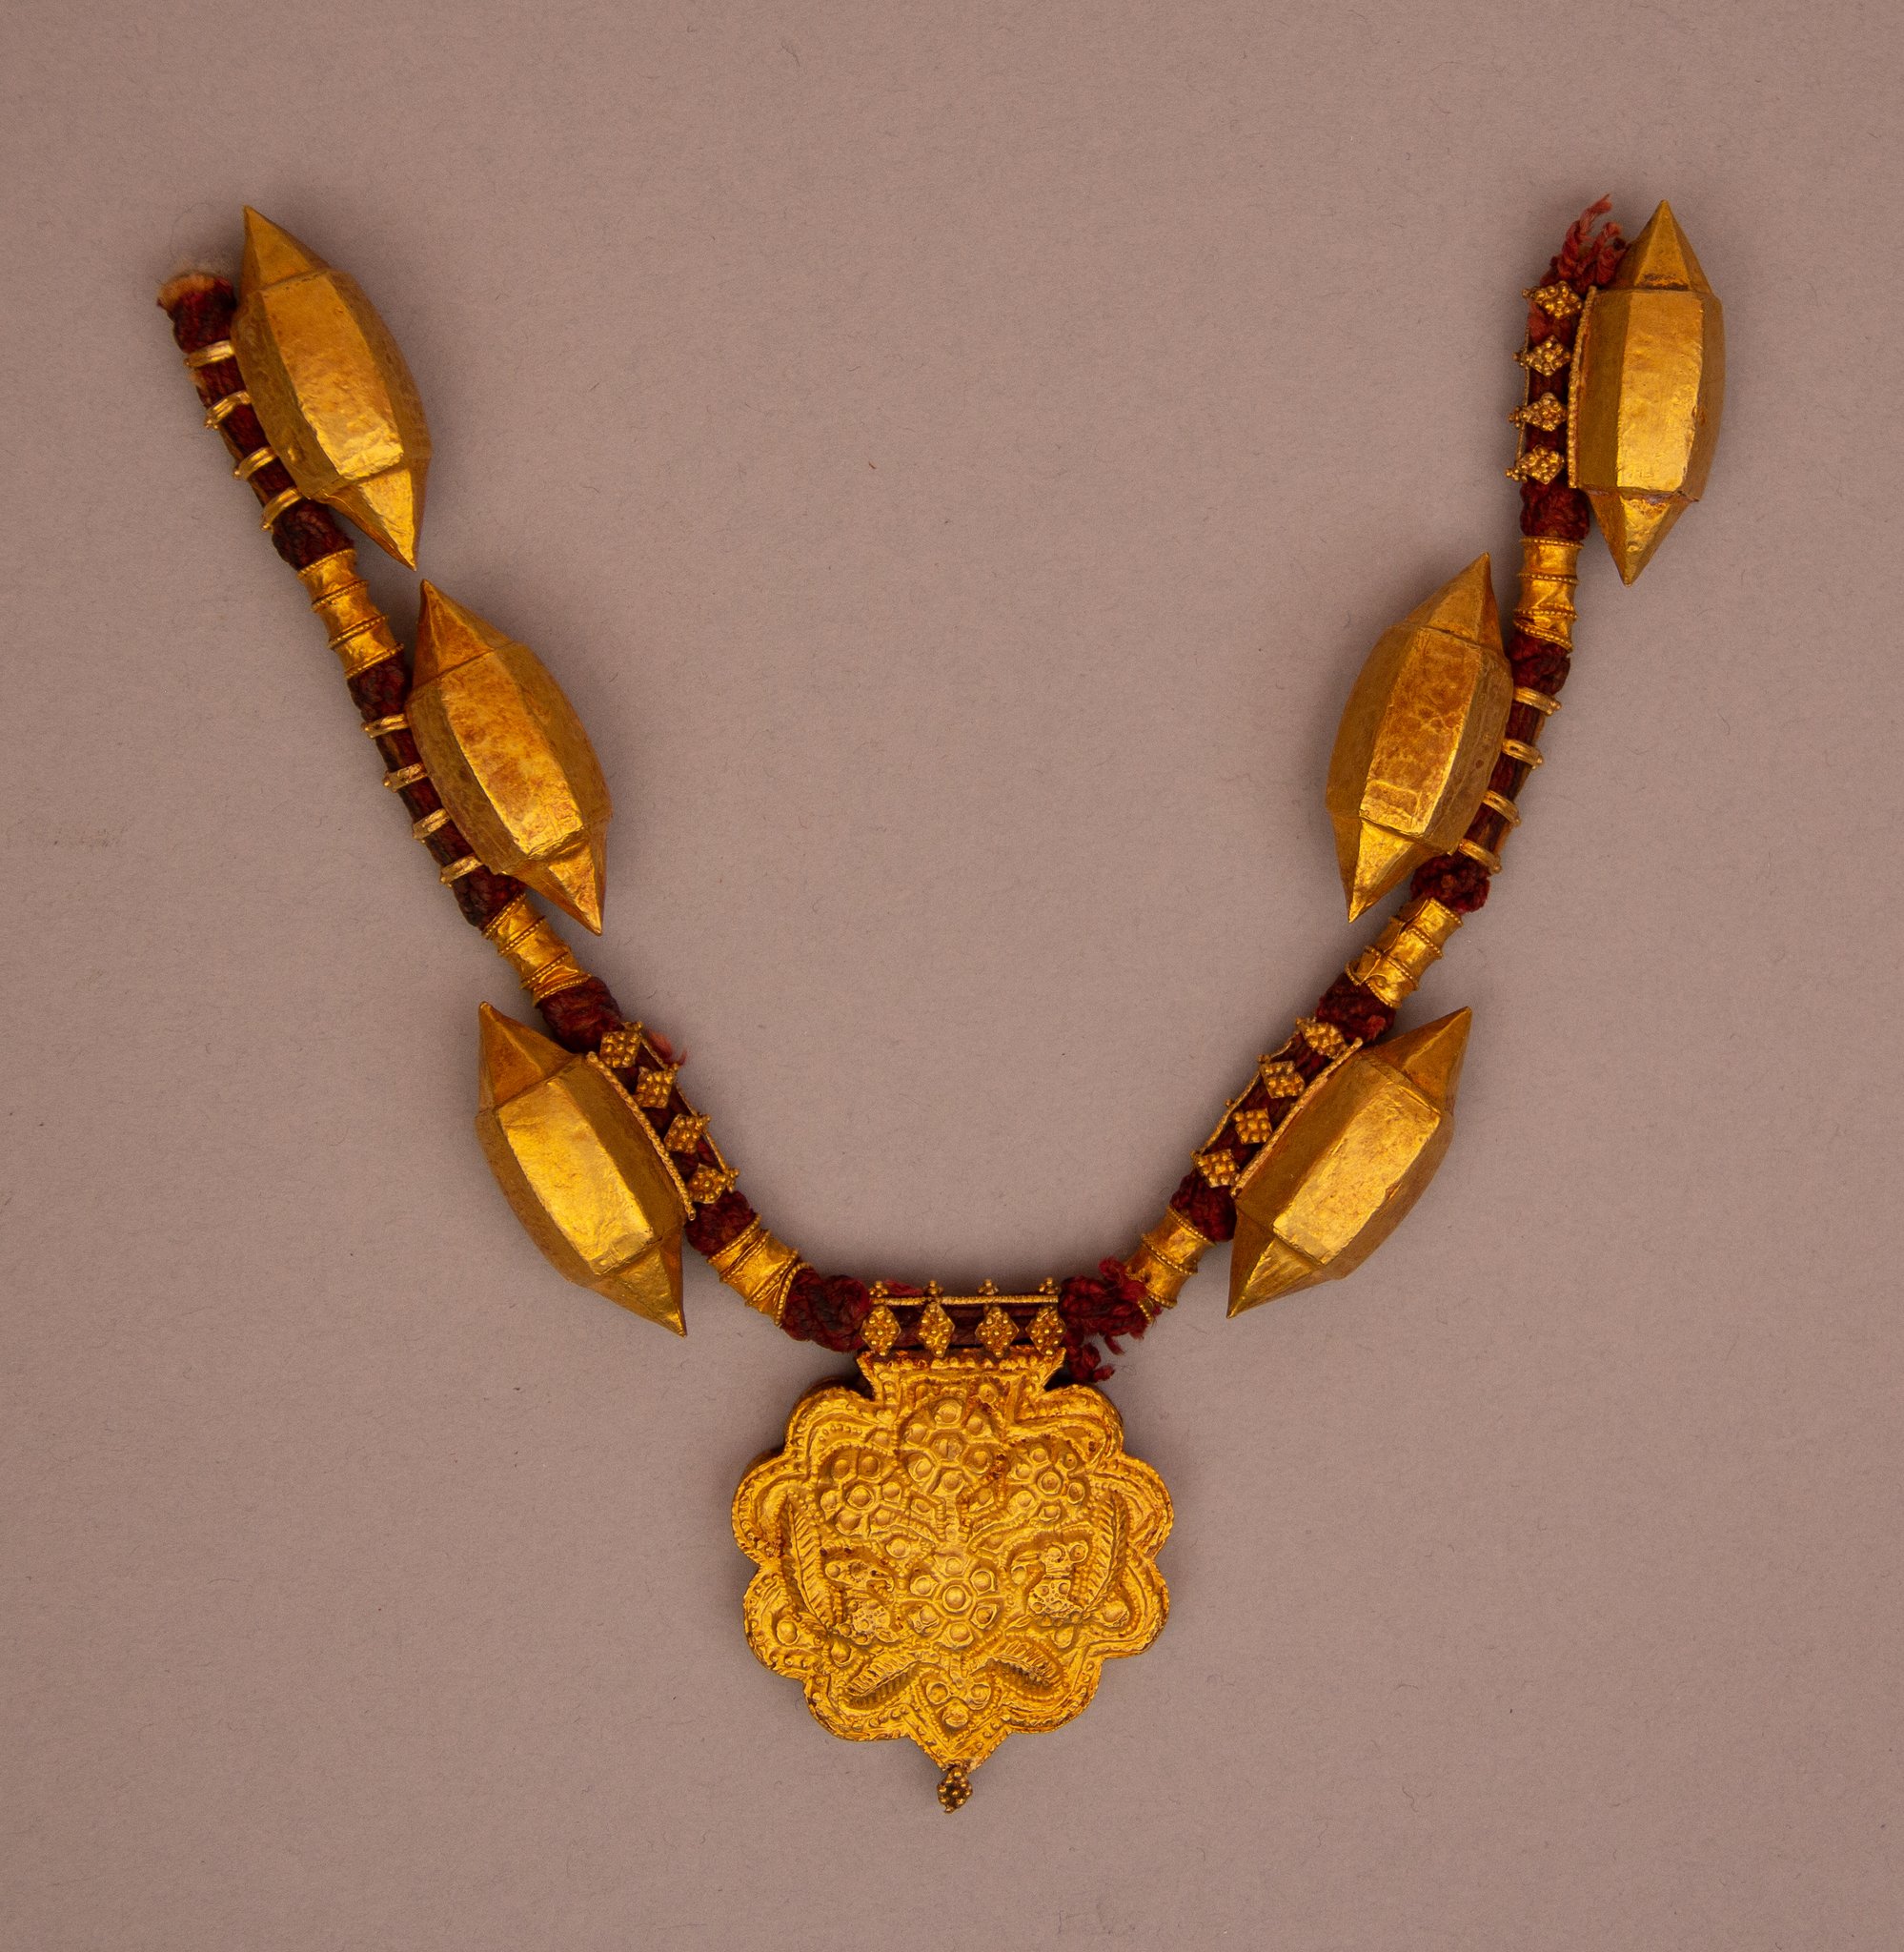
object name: necklace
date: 1701-1900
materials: gold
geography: india